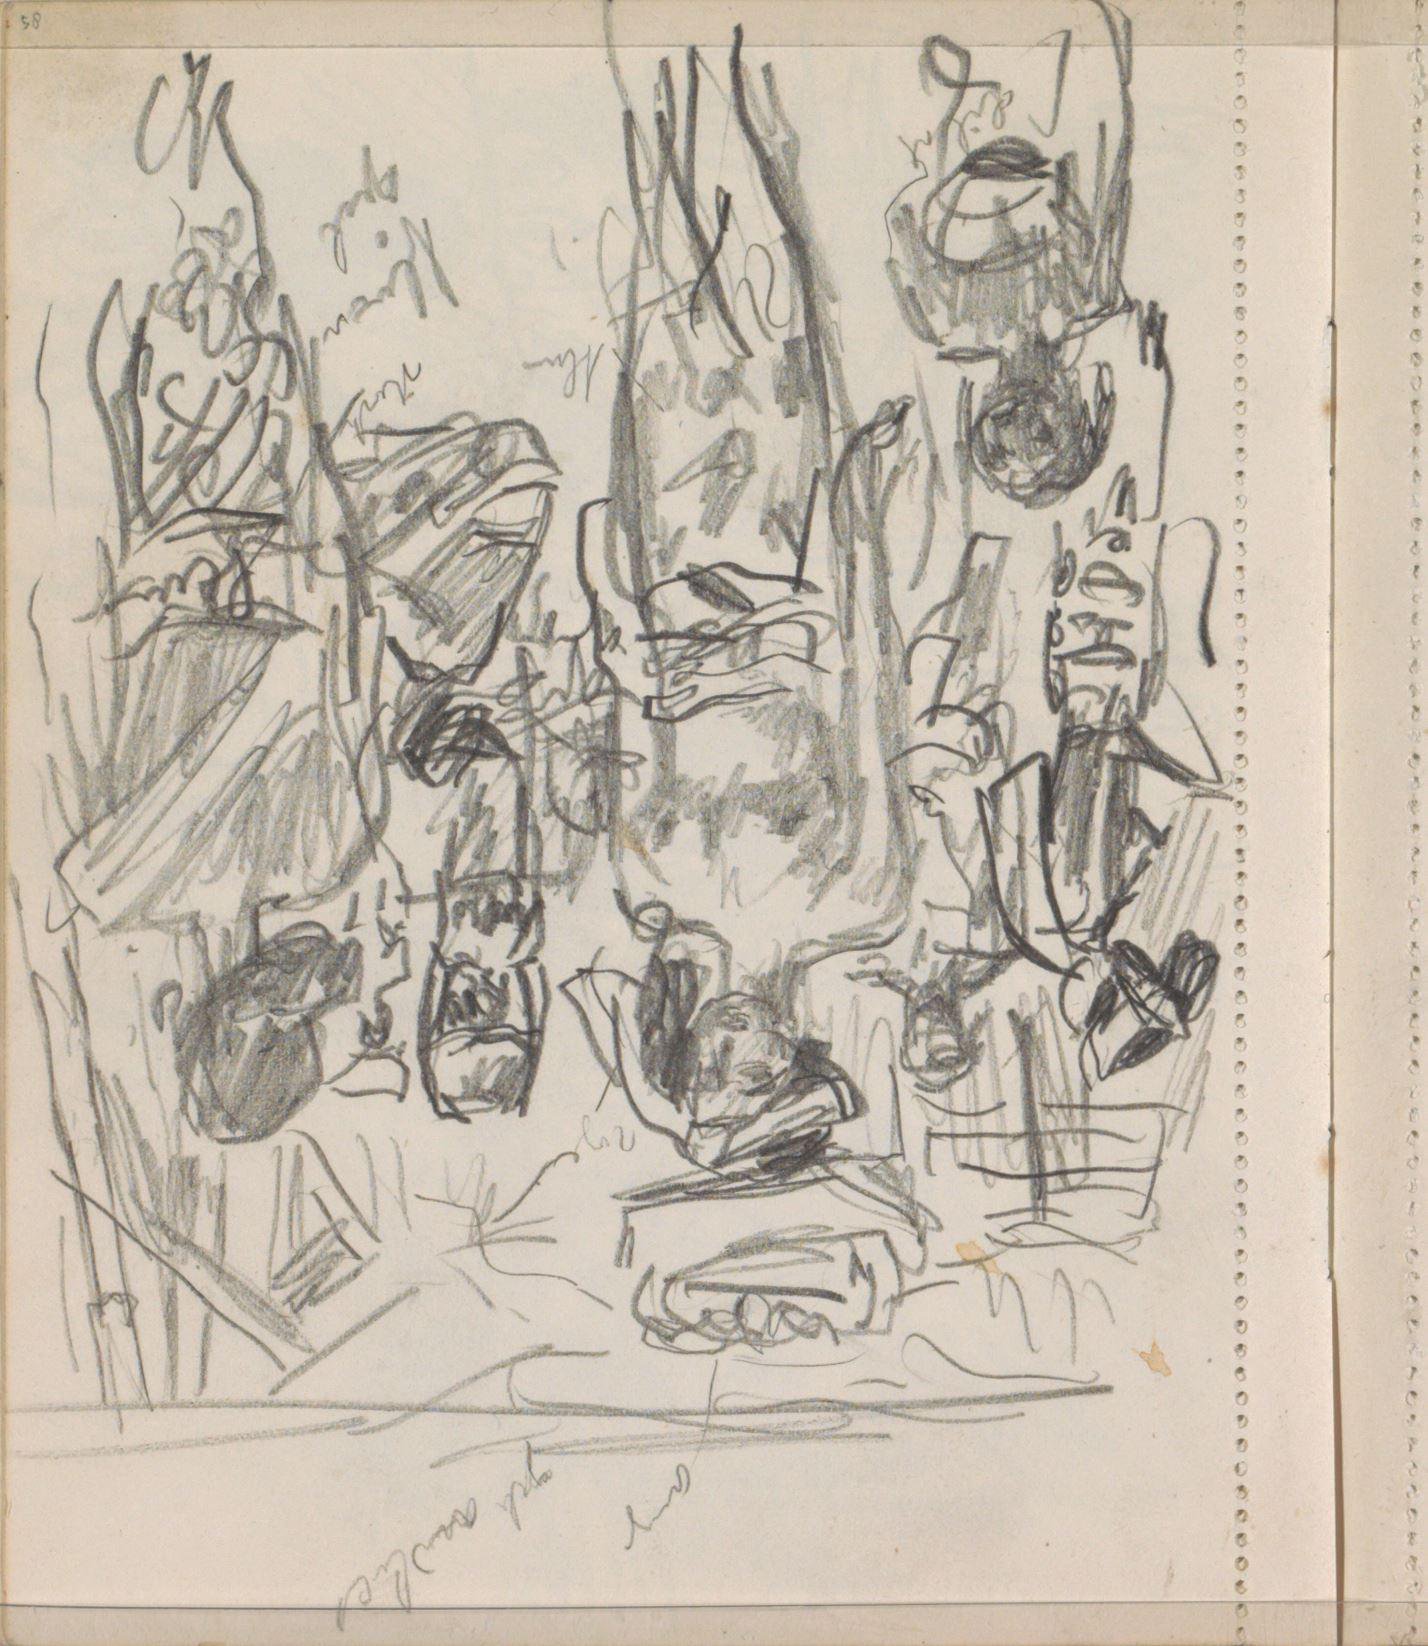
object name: sketchbook leaf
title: Straat met figuren, waaronder vrouwen met schalen op het hoofd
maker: marius bauer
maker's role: draughtsman, print maker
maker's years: 1867-1932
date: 1925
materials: paper, pencil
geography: indonesia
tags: asiatic races and peoples, folk costume, regional costume, carrying something on the head or on the shoulders, street (+ city(-scape) with figures, staffage)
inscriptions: kleurnotitie, handgeschreven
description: Pagina 58 uit een schetsboek met 67 bladen.